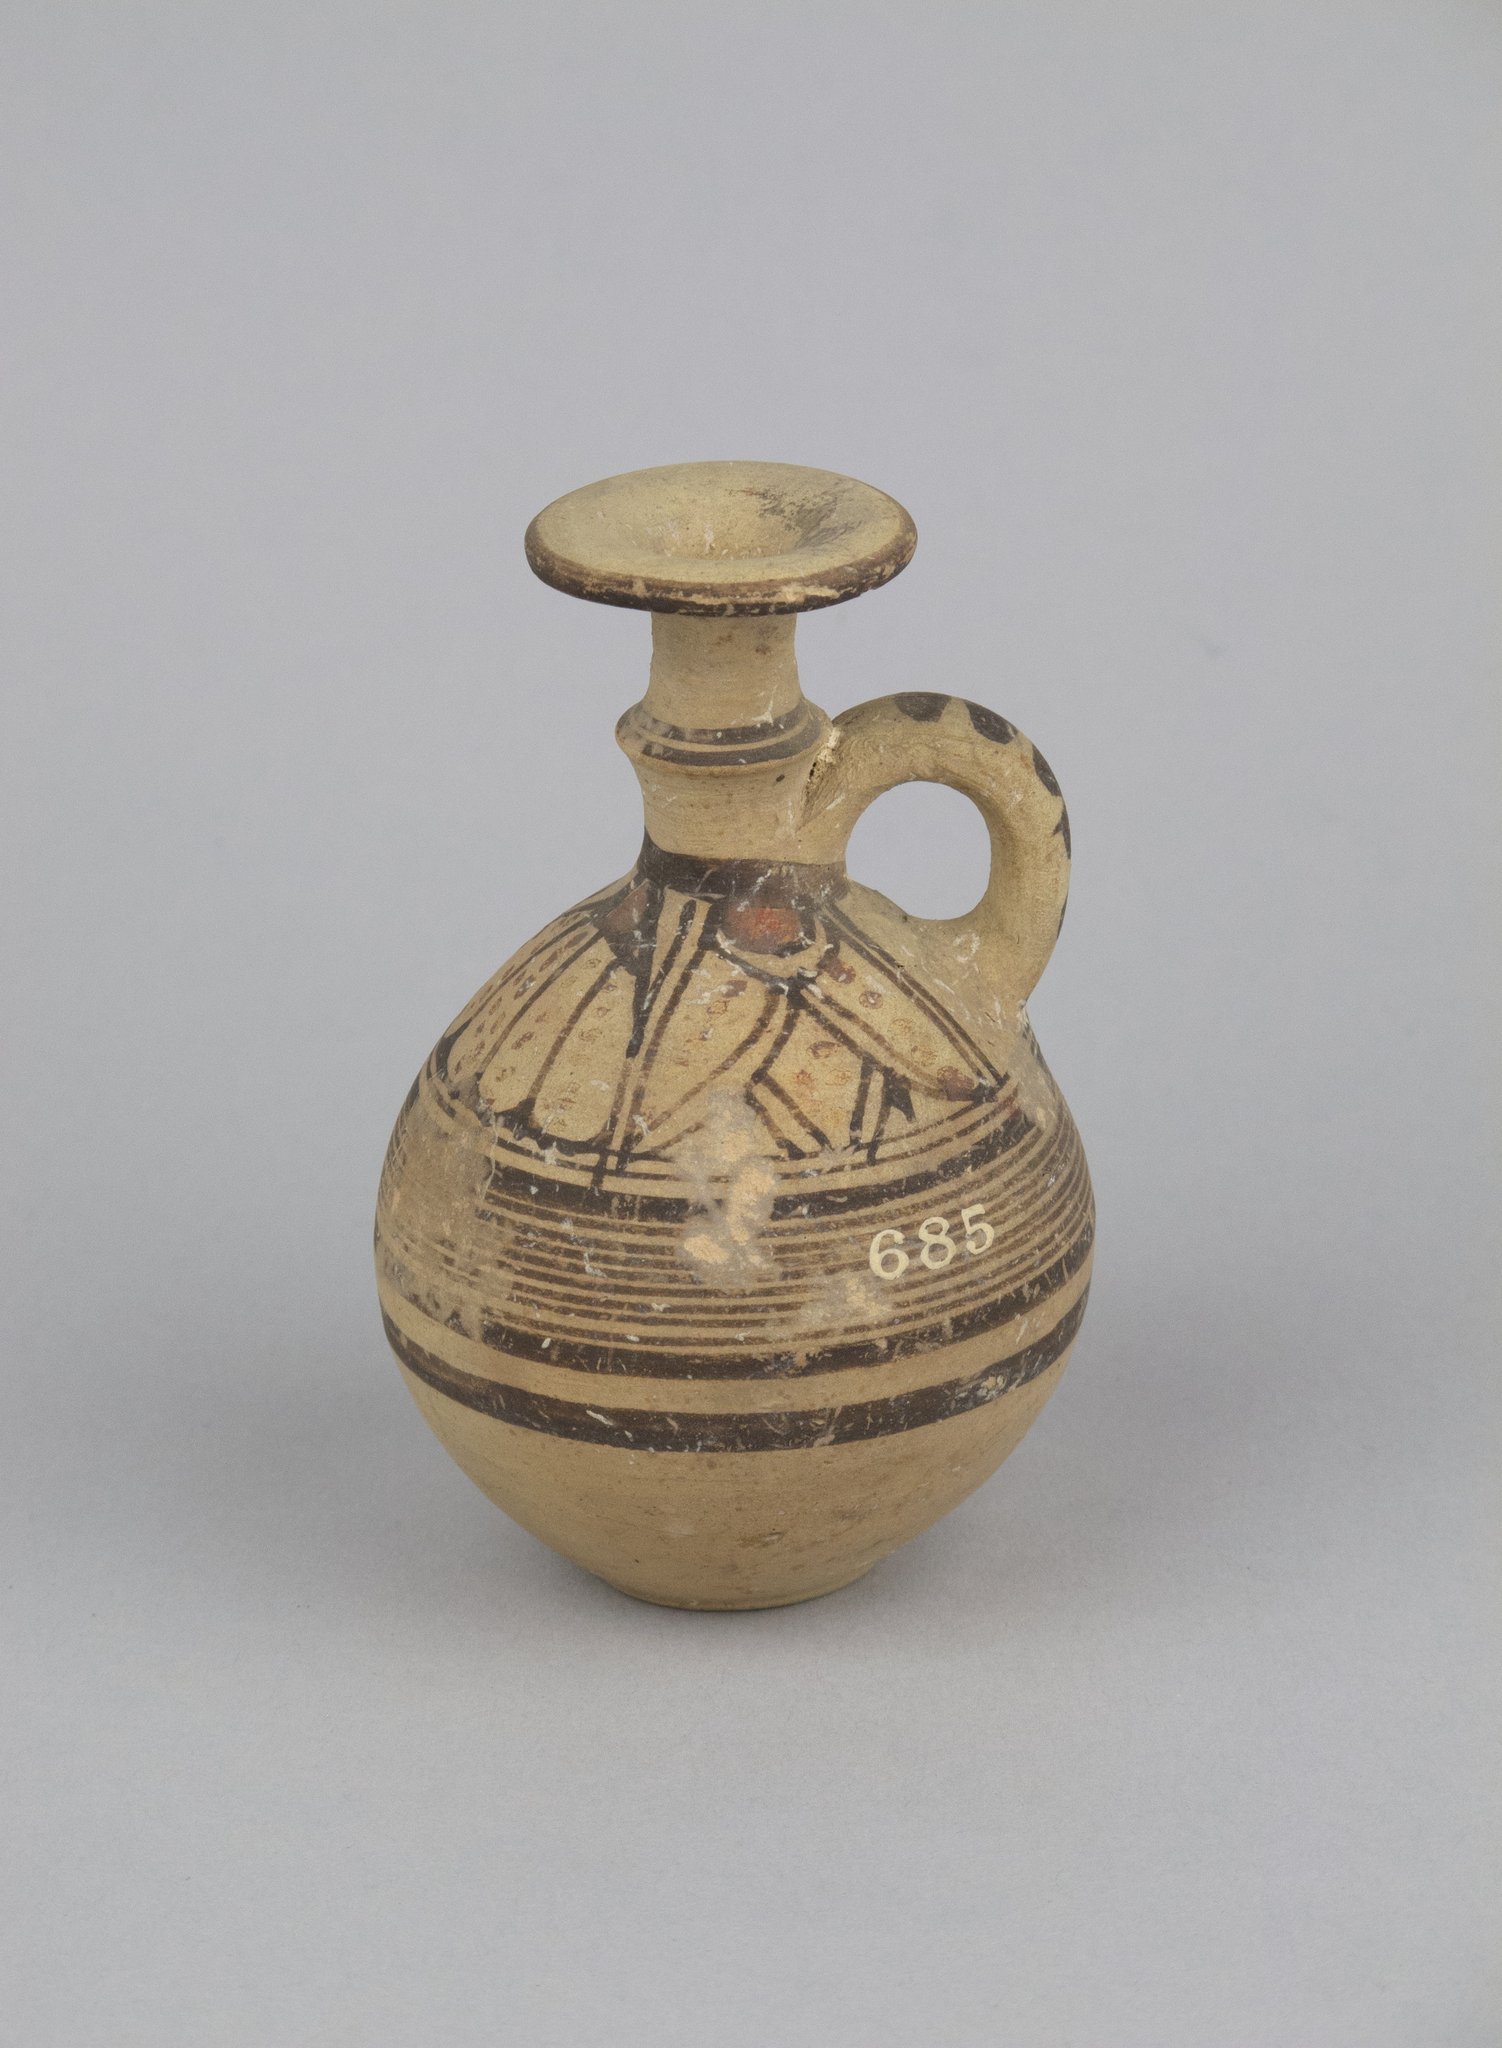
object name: juglet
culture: cypriot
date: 750-600 BCE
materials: terracotta